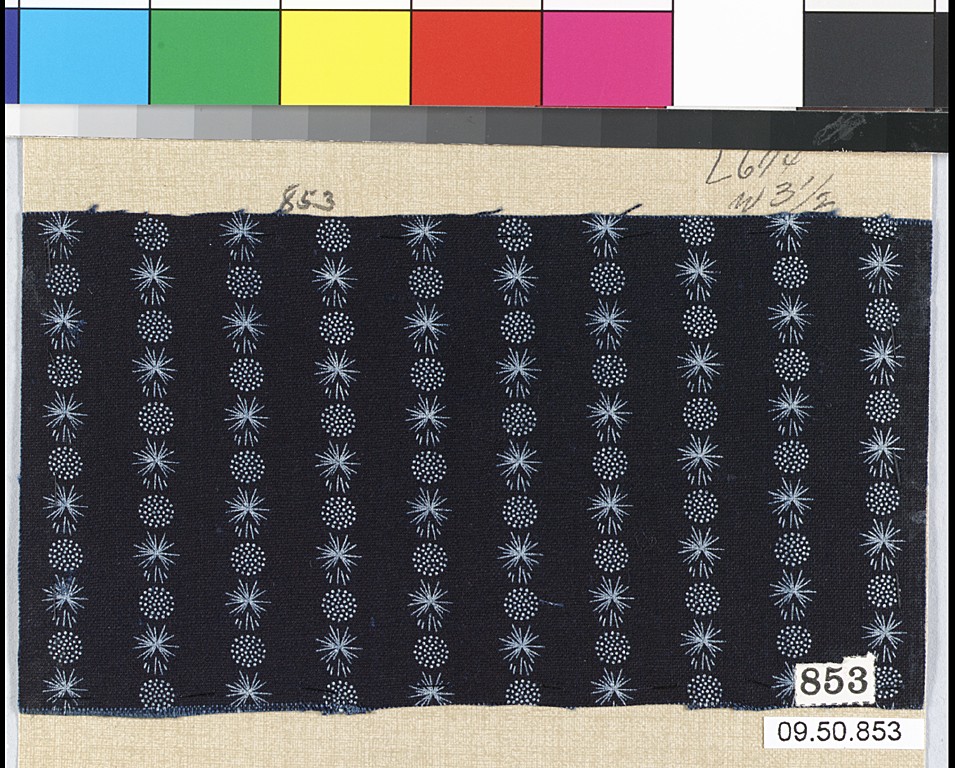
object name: piece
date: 1801-1900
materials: cotton